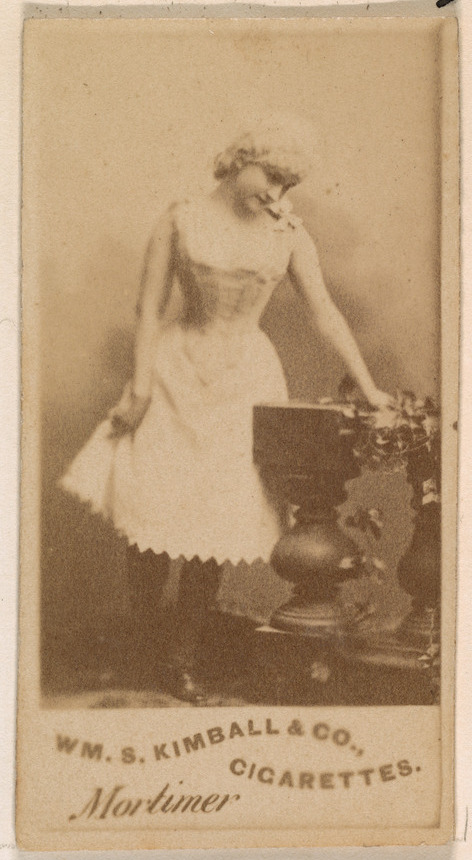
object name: photograph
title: Miss Mortimer, from the Actresses series (N203) issued by Wm. S. Kimball & Co.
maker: william s. kimball & company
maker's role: publisher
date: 1889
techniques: color lithograph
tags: portraits,women,actresses